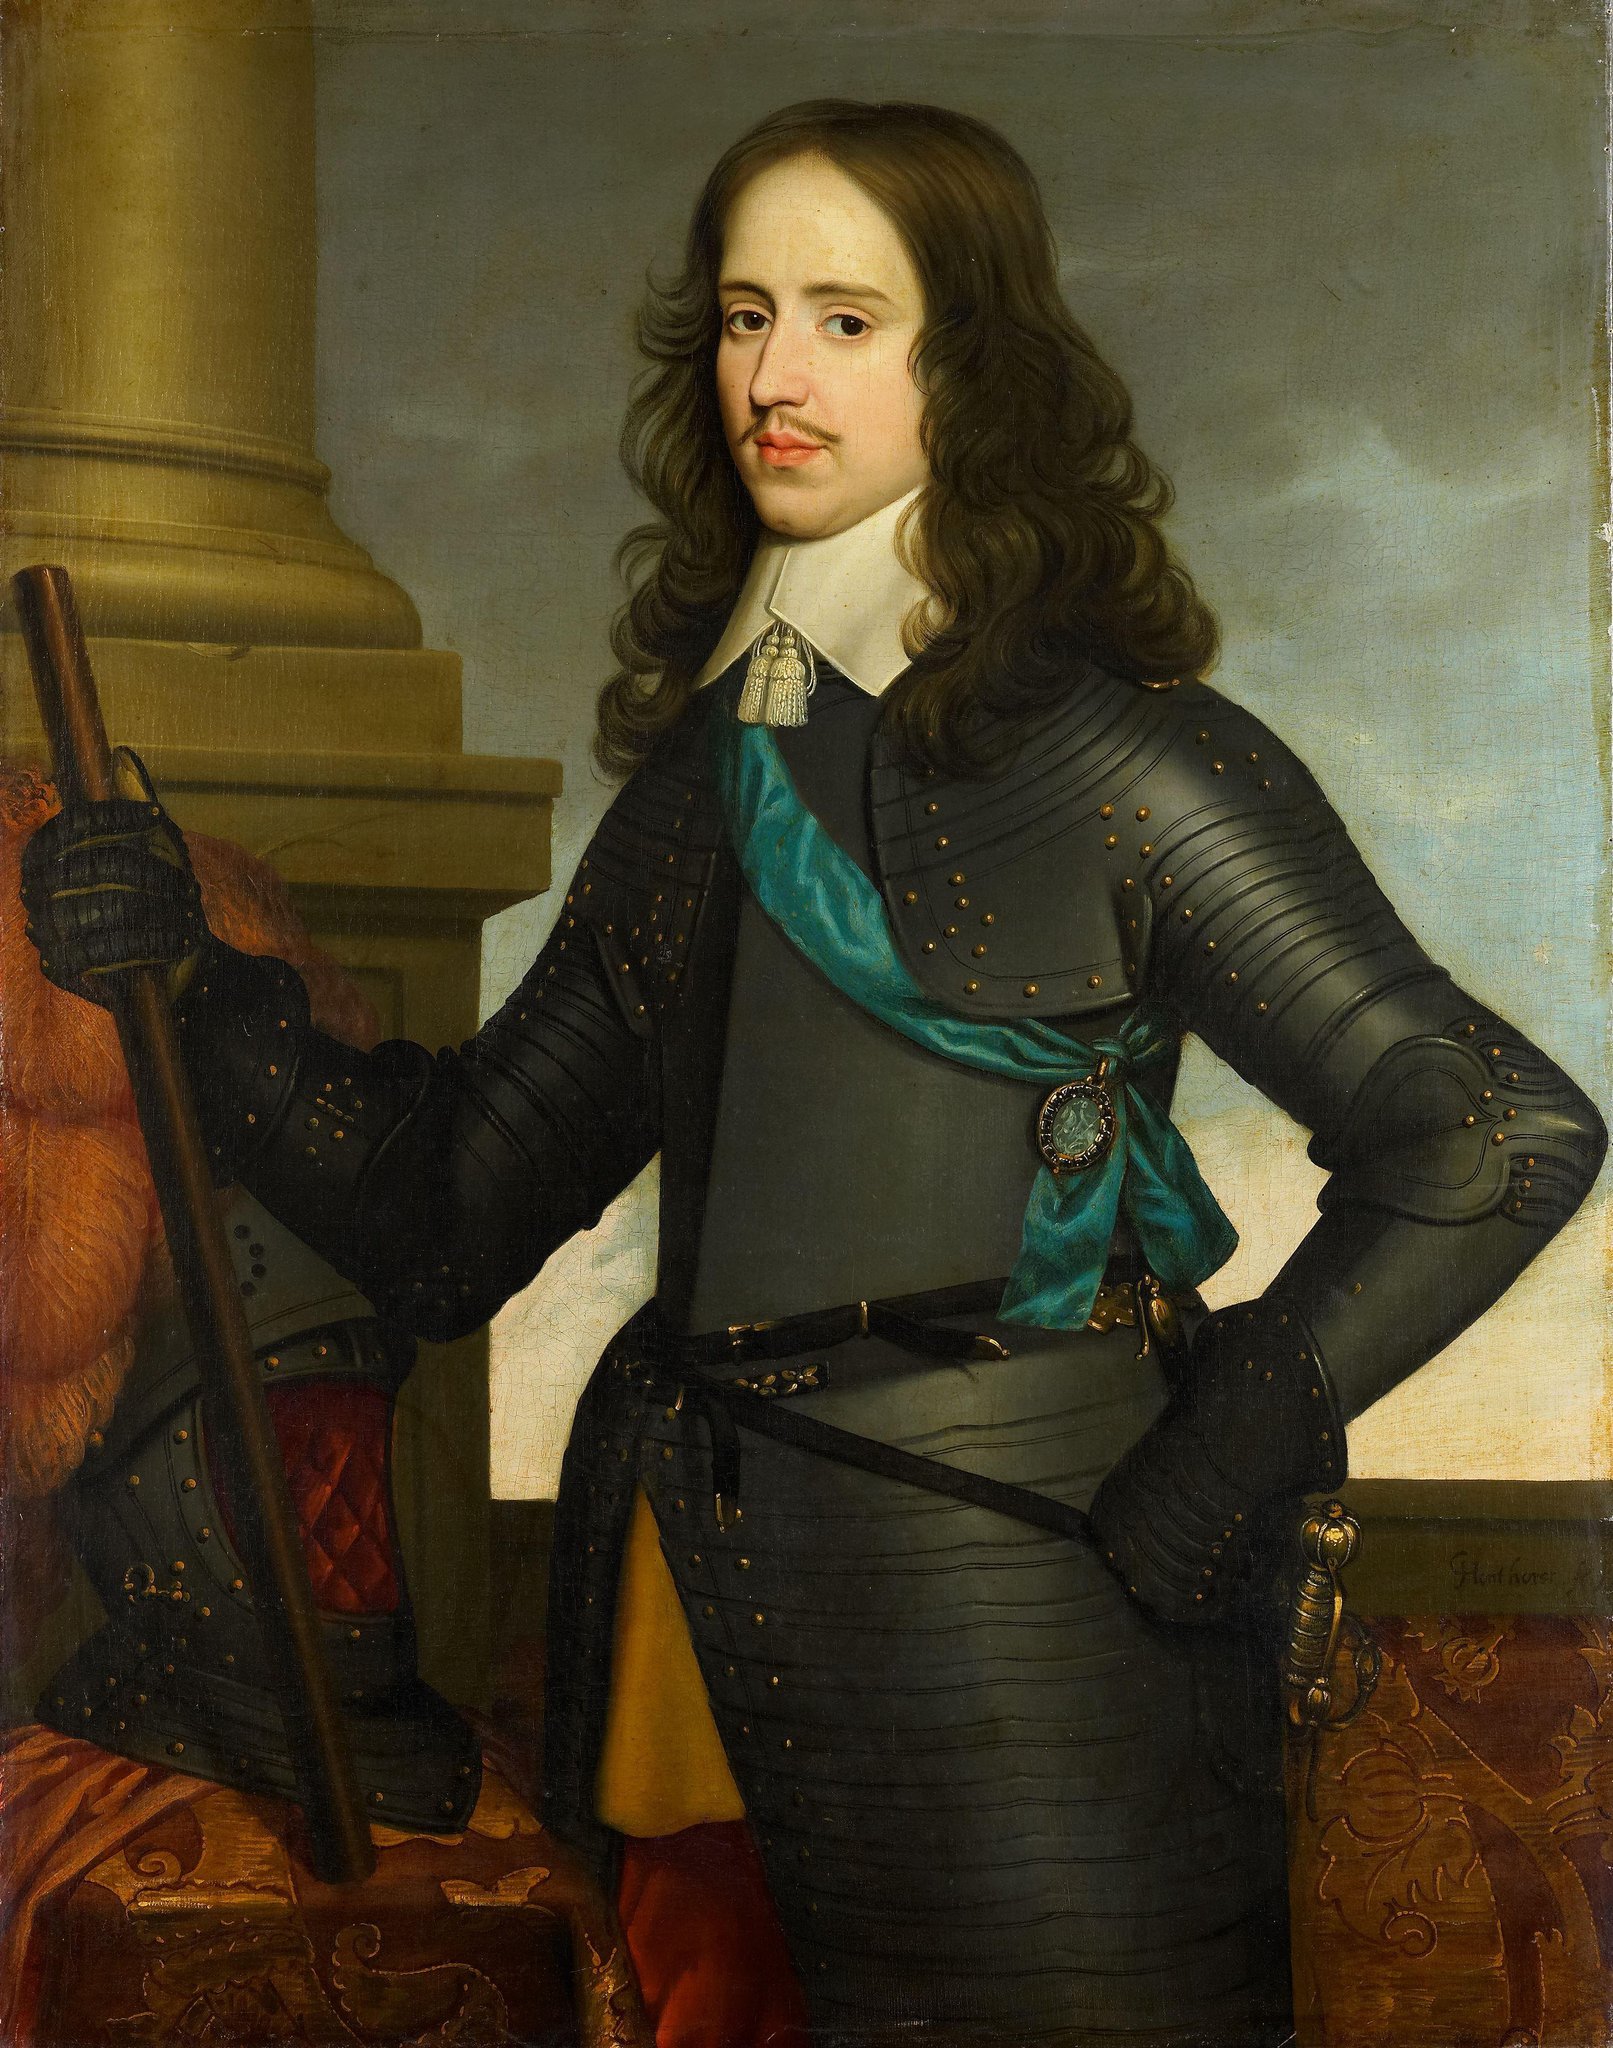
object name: painting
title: Portrait of Willem II (1626-50), Prince of Orange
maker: gerard van honthorst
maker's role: draughtsman, painter, print maker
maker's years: 1592-1656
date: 1651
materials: canvas, oil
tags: william ii (prince of orange), historical persons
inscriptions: signature and date, lower right (G and H ligated): ‘GHonthorst ƒc 1651’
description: Portret van Willem II, prins van Oranje. Staande ten halven lijve voor een balustrade met zuil. In wapenrusting, commadostaf in rechterhand, de linkerhand in de zij. Zijn gepluimde helm staat links op een tafeltje. Herhaling van het origineel door Gerard van Honthorst, SK-A-871.